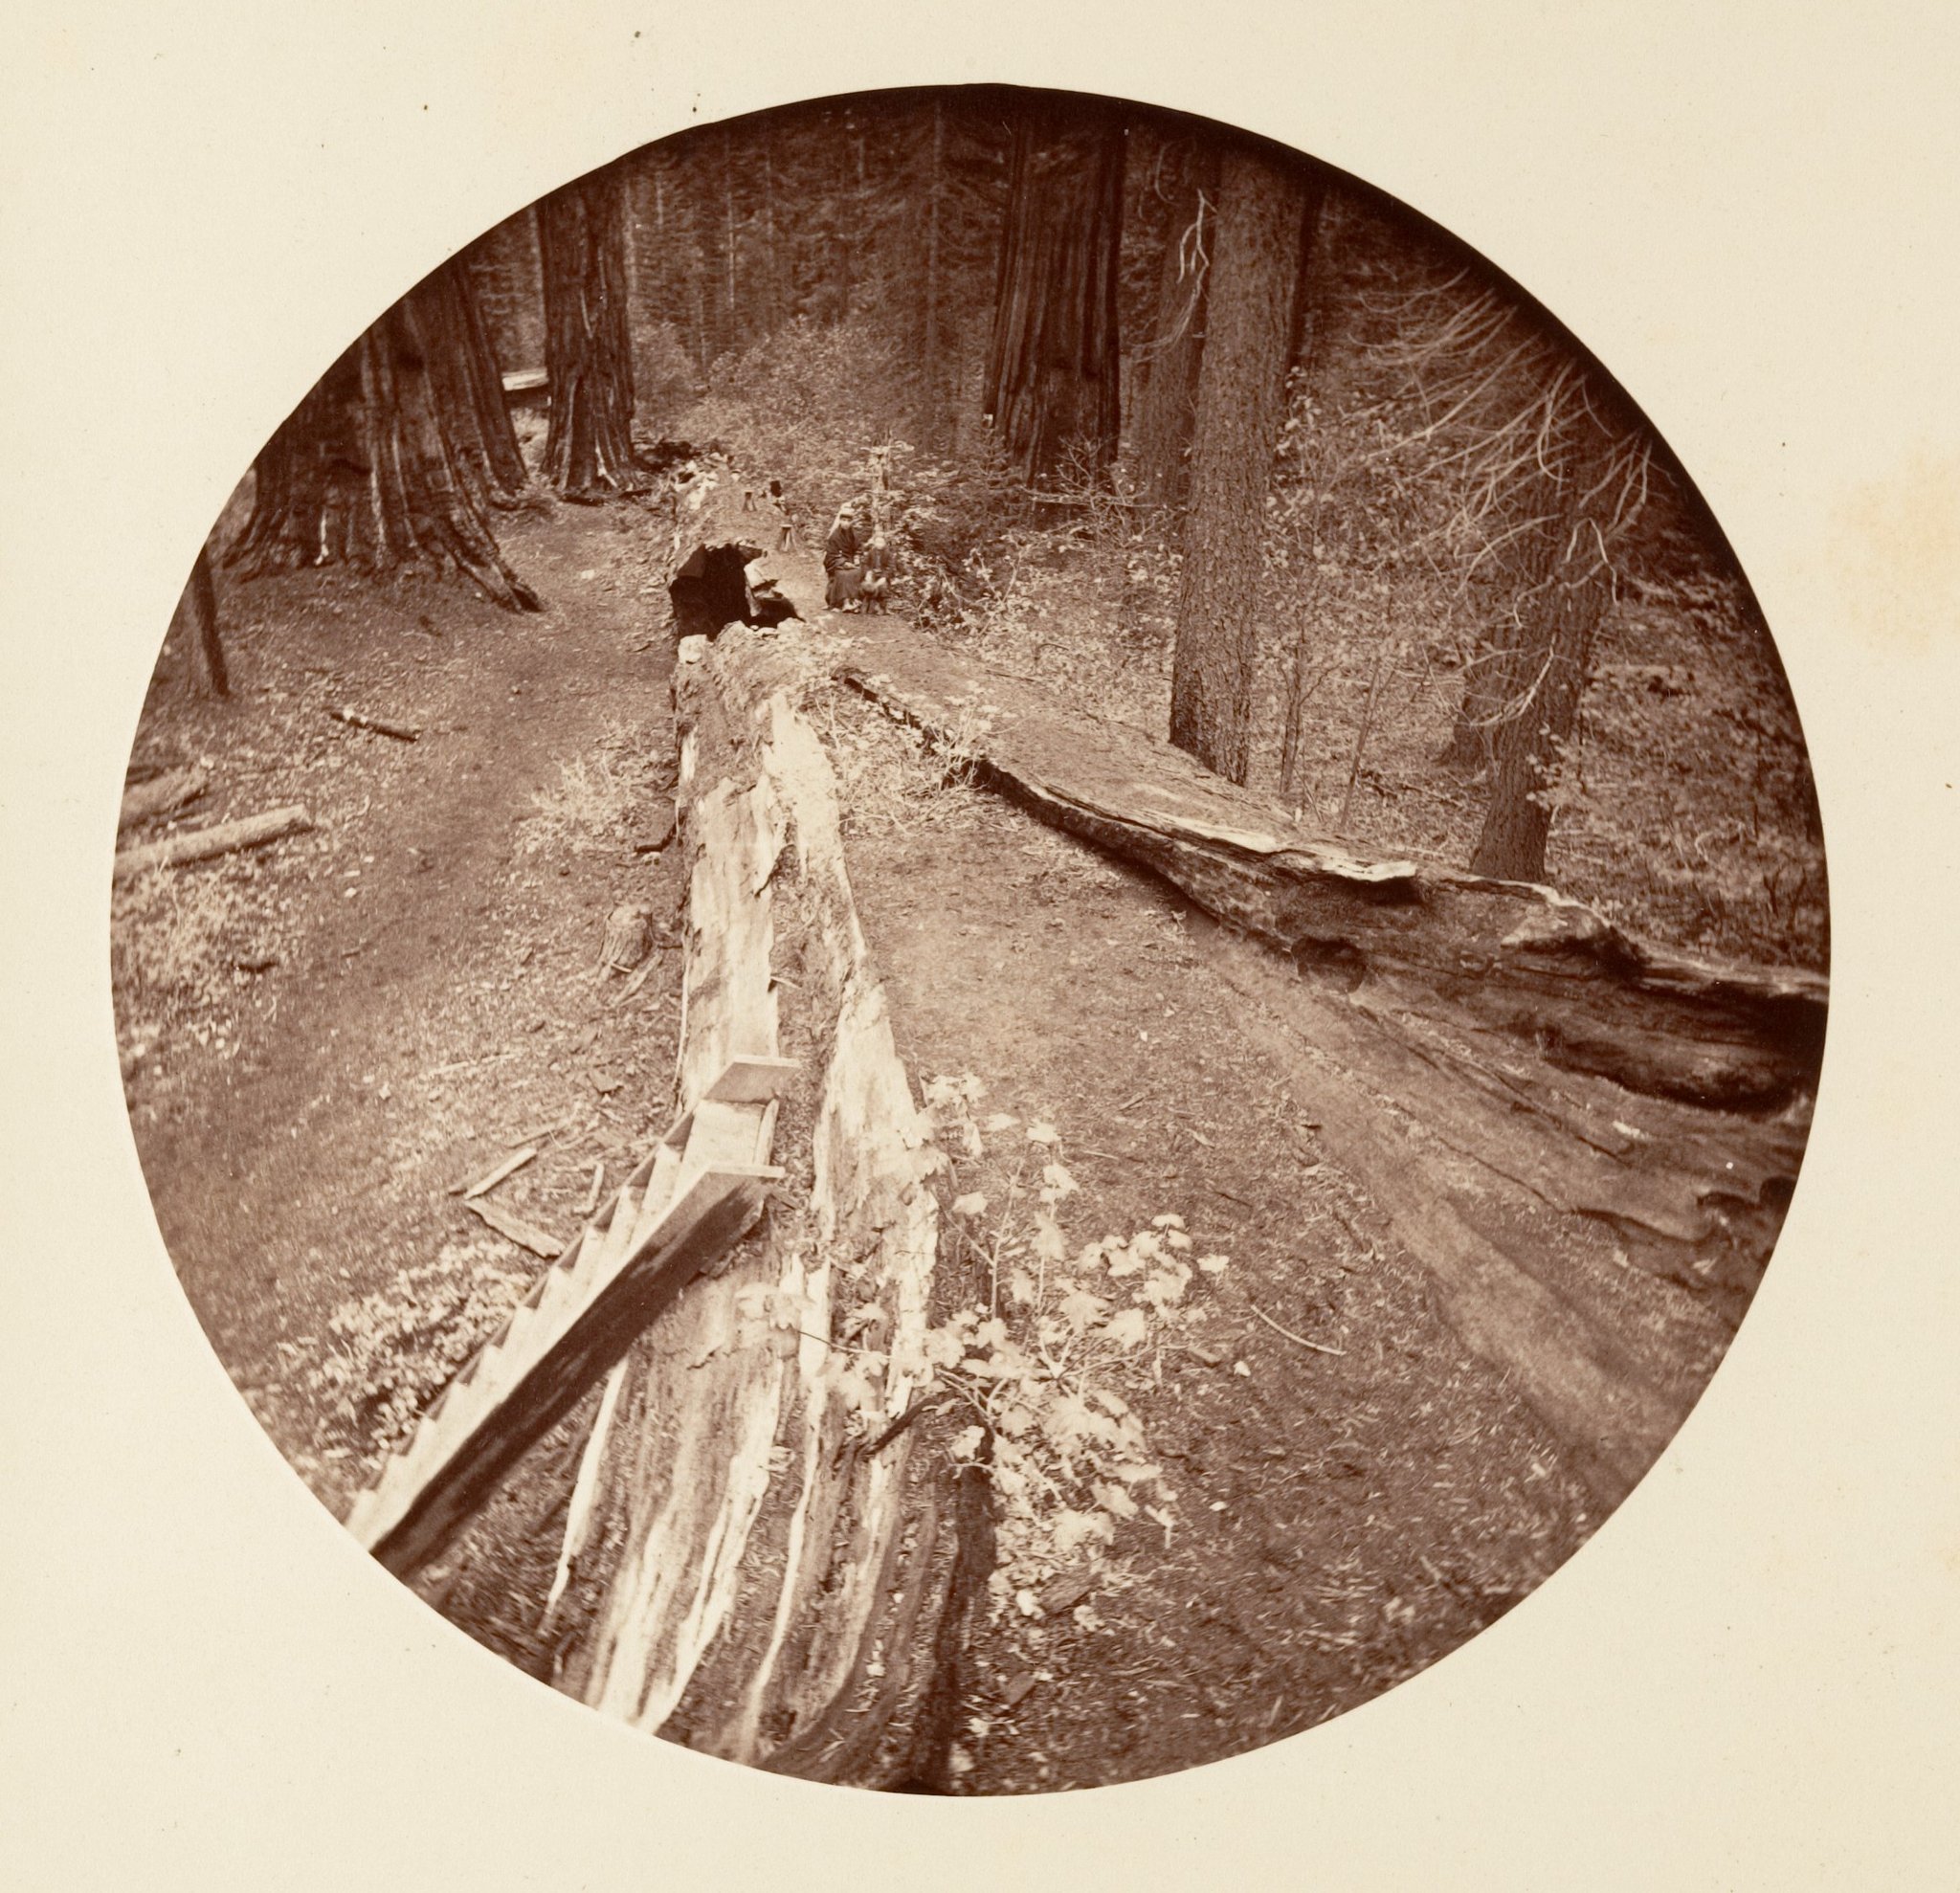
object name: photograph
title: The Father of the Forest 450 Ft Long, C. Grove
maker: carleton e. watkins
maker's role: artist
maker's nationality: american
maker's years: 1829-1916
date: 1878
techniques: albumen silver print, glass negative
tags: forests,trees